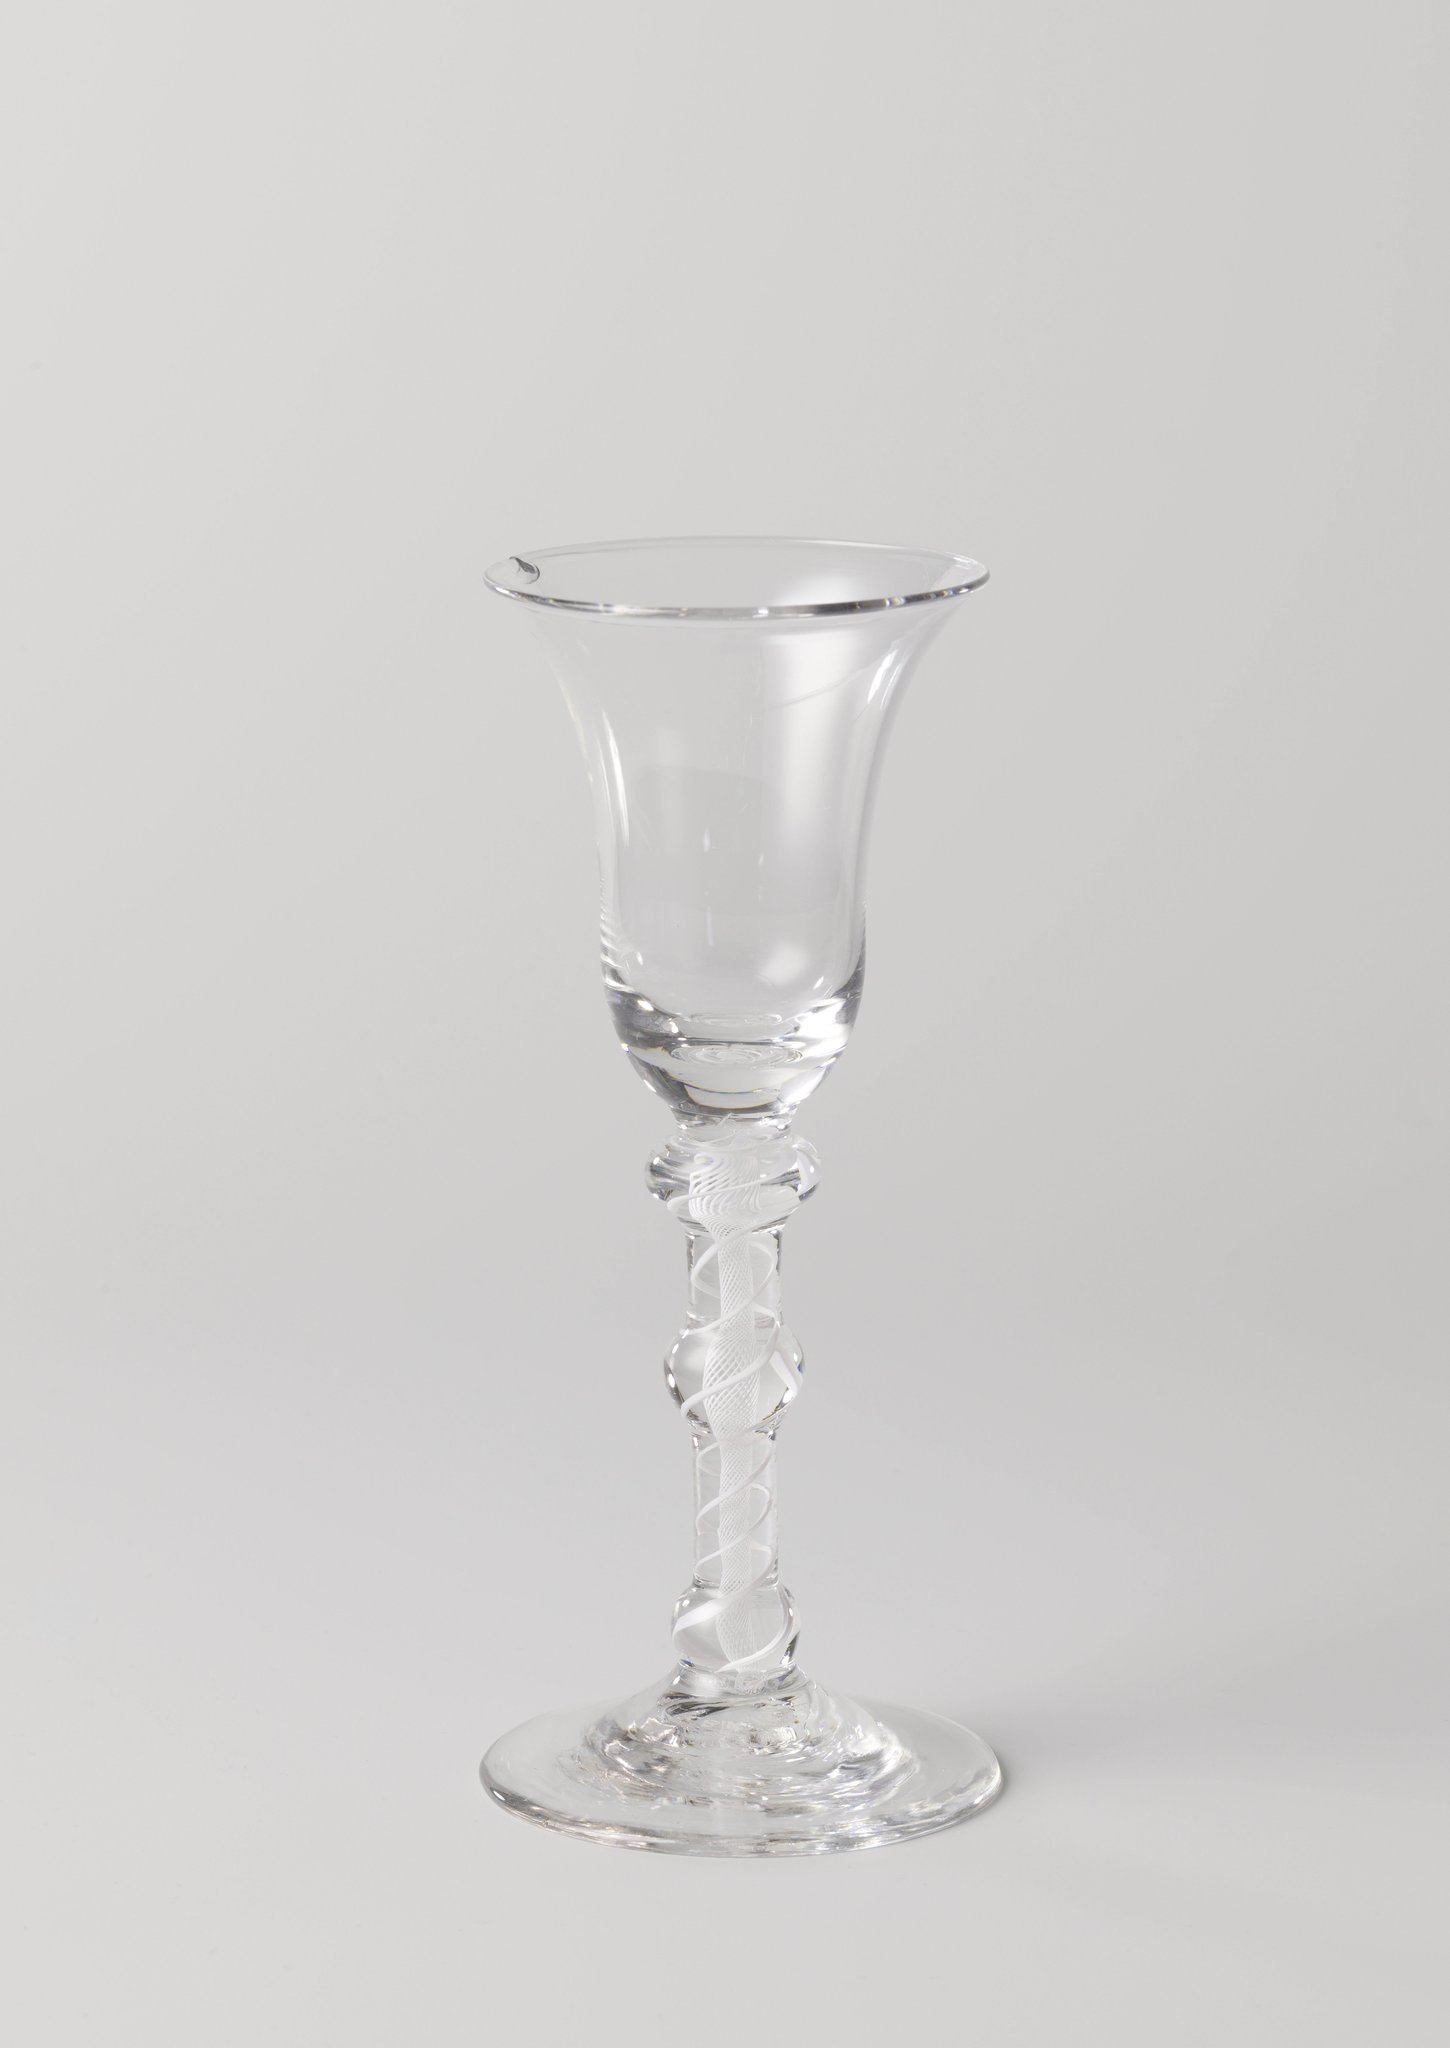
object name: goblet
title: Slingerglas met klokvormige kelk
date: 1750-1775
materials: glass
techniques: glassblowing, vetro a retorti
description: Slingerglas met conische voet en balustroïde stam. In de stam opaak witte slinger rond witte netwerkspiraal. Klokvormige kelk.